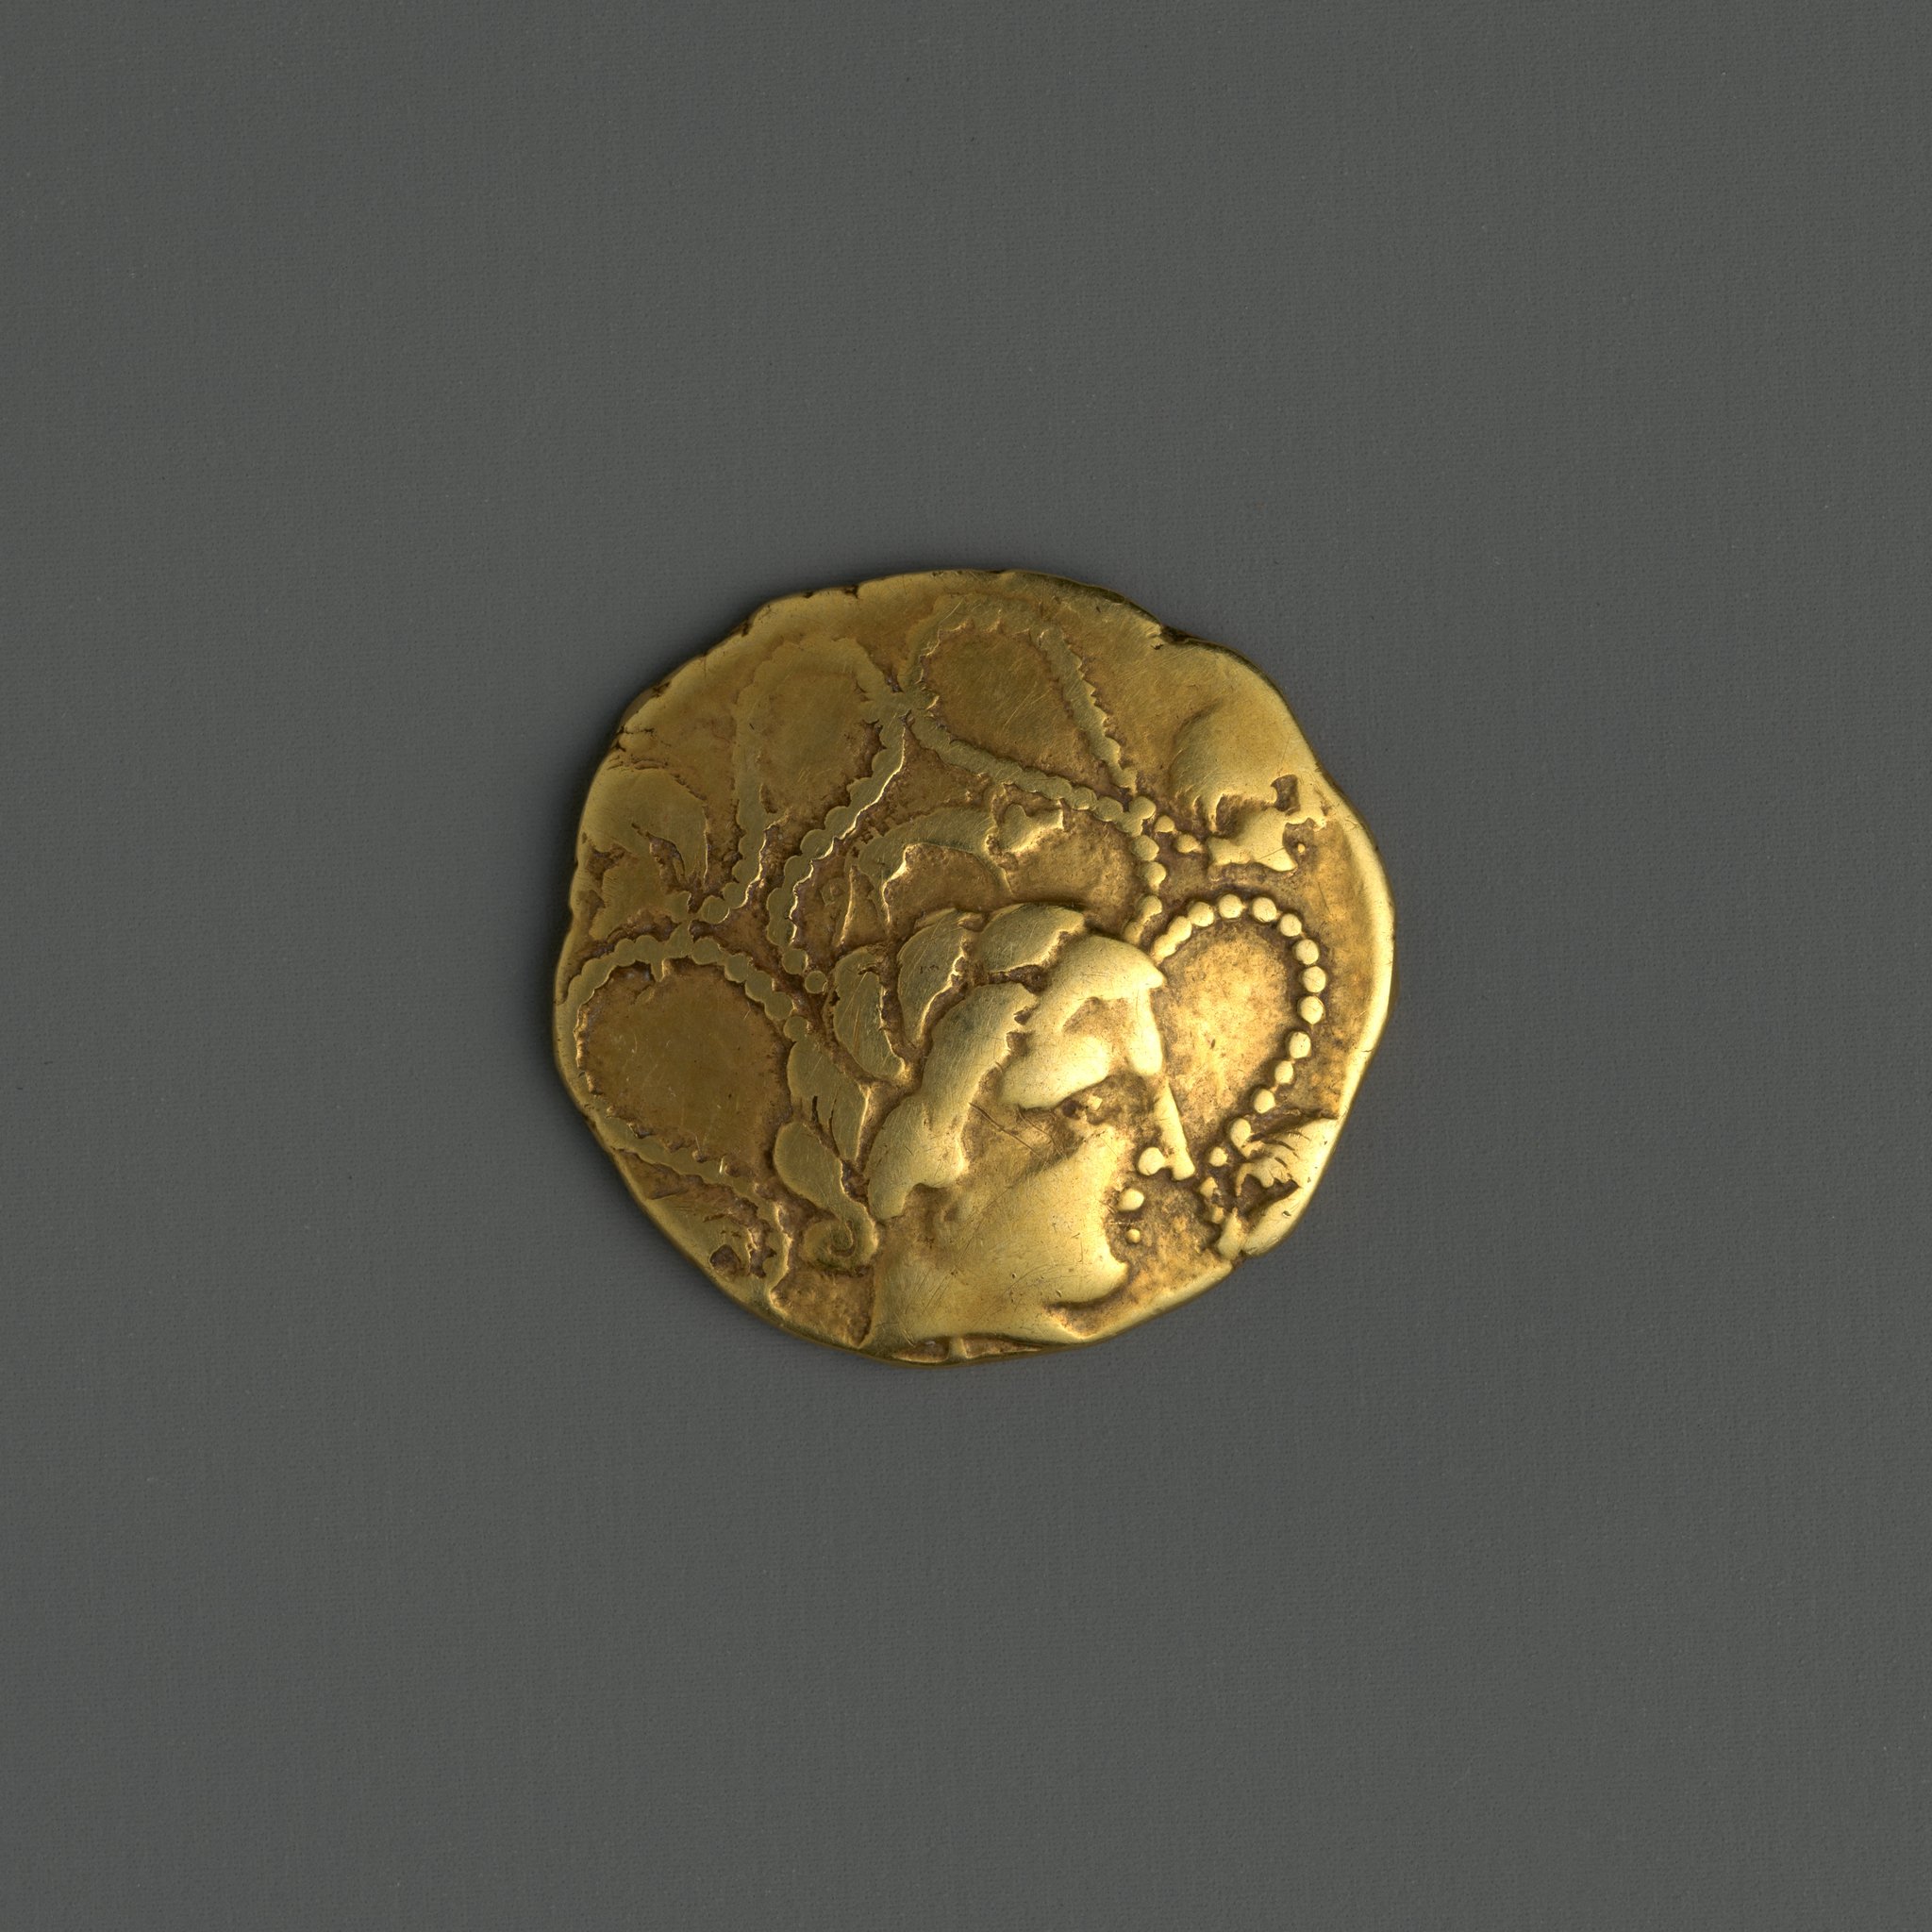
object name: coin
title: Gold Coin of the Veneti or Namneti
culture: celtic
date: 167-135 BCE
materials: gold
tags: faces,men